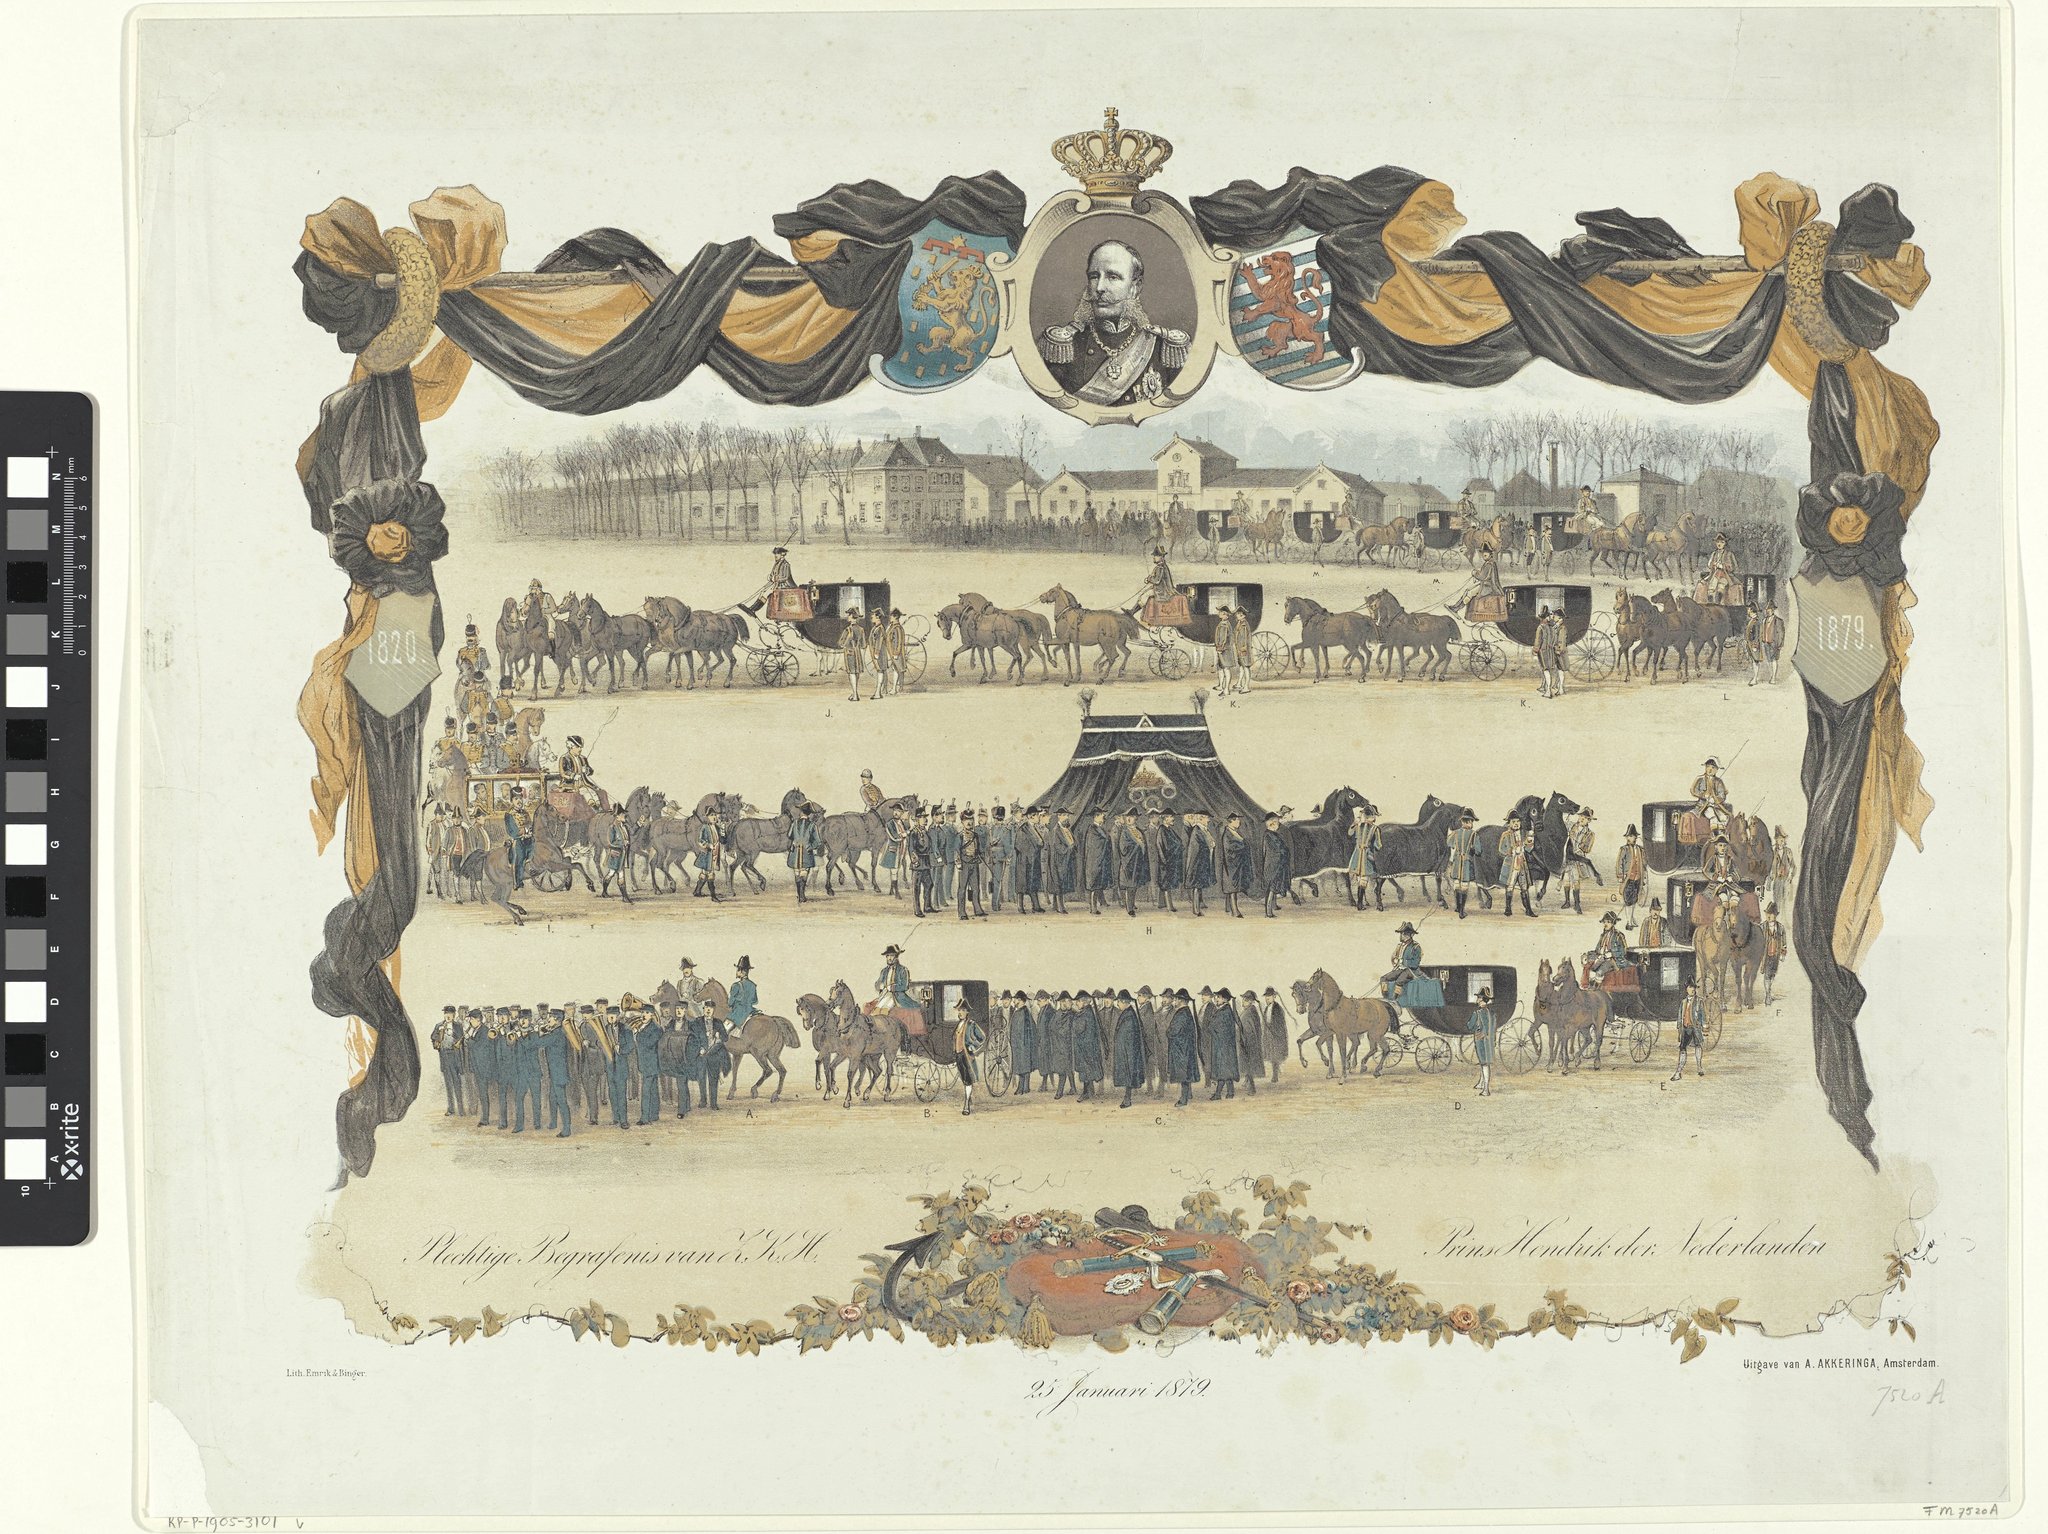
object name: print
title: Plechtige Begrafenis van Z.K.H. Prins Hendrik der Nederlanden 25 Januari 1879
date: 1879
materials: paper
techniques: lithograph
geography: netherlands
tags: hendrik (prins der nederlanden), cortege, funeral procession, public funeral, delft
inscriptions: collector's mark: Lugt 2228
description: Begrafenis van Prins Hendrik de Zeevaarder te Delft op 25 januari 1879. De begrafenisstoet slingert in vier rijen over een plein. Onderdelen in de stoet aangeduid met de letters A-M. Voorstelling binnen een omlijsting van gedrapeerde oranje en zwarte rouwdoeken. Bovenaan een portret van de overleden prins. Onderaan de sabel, verrekijker en een onderscheidingsteken van de prins liggend op een kussen bij een anker. Bij de prent behoort een (fragment van een) verklaring.